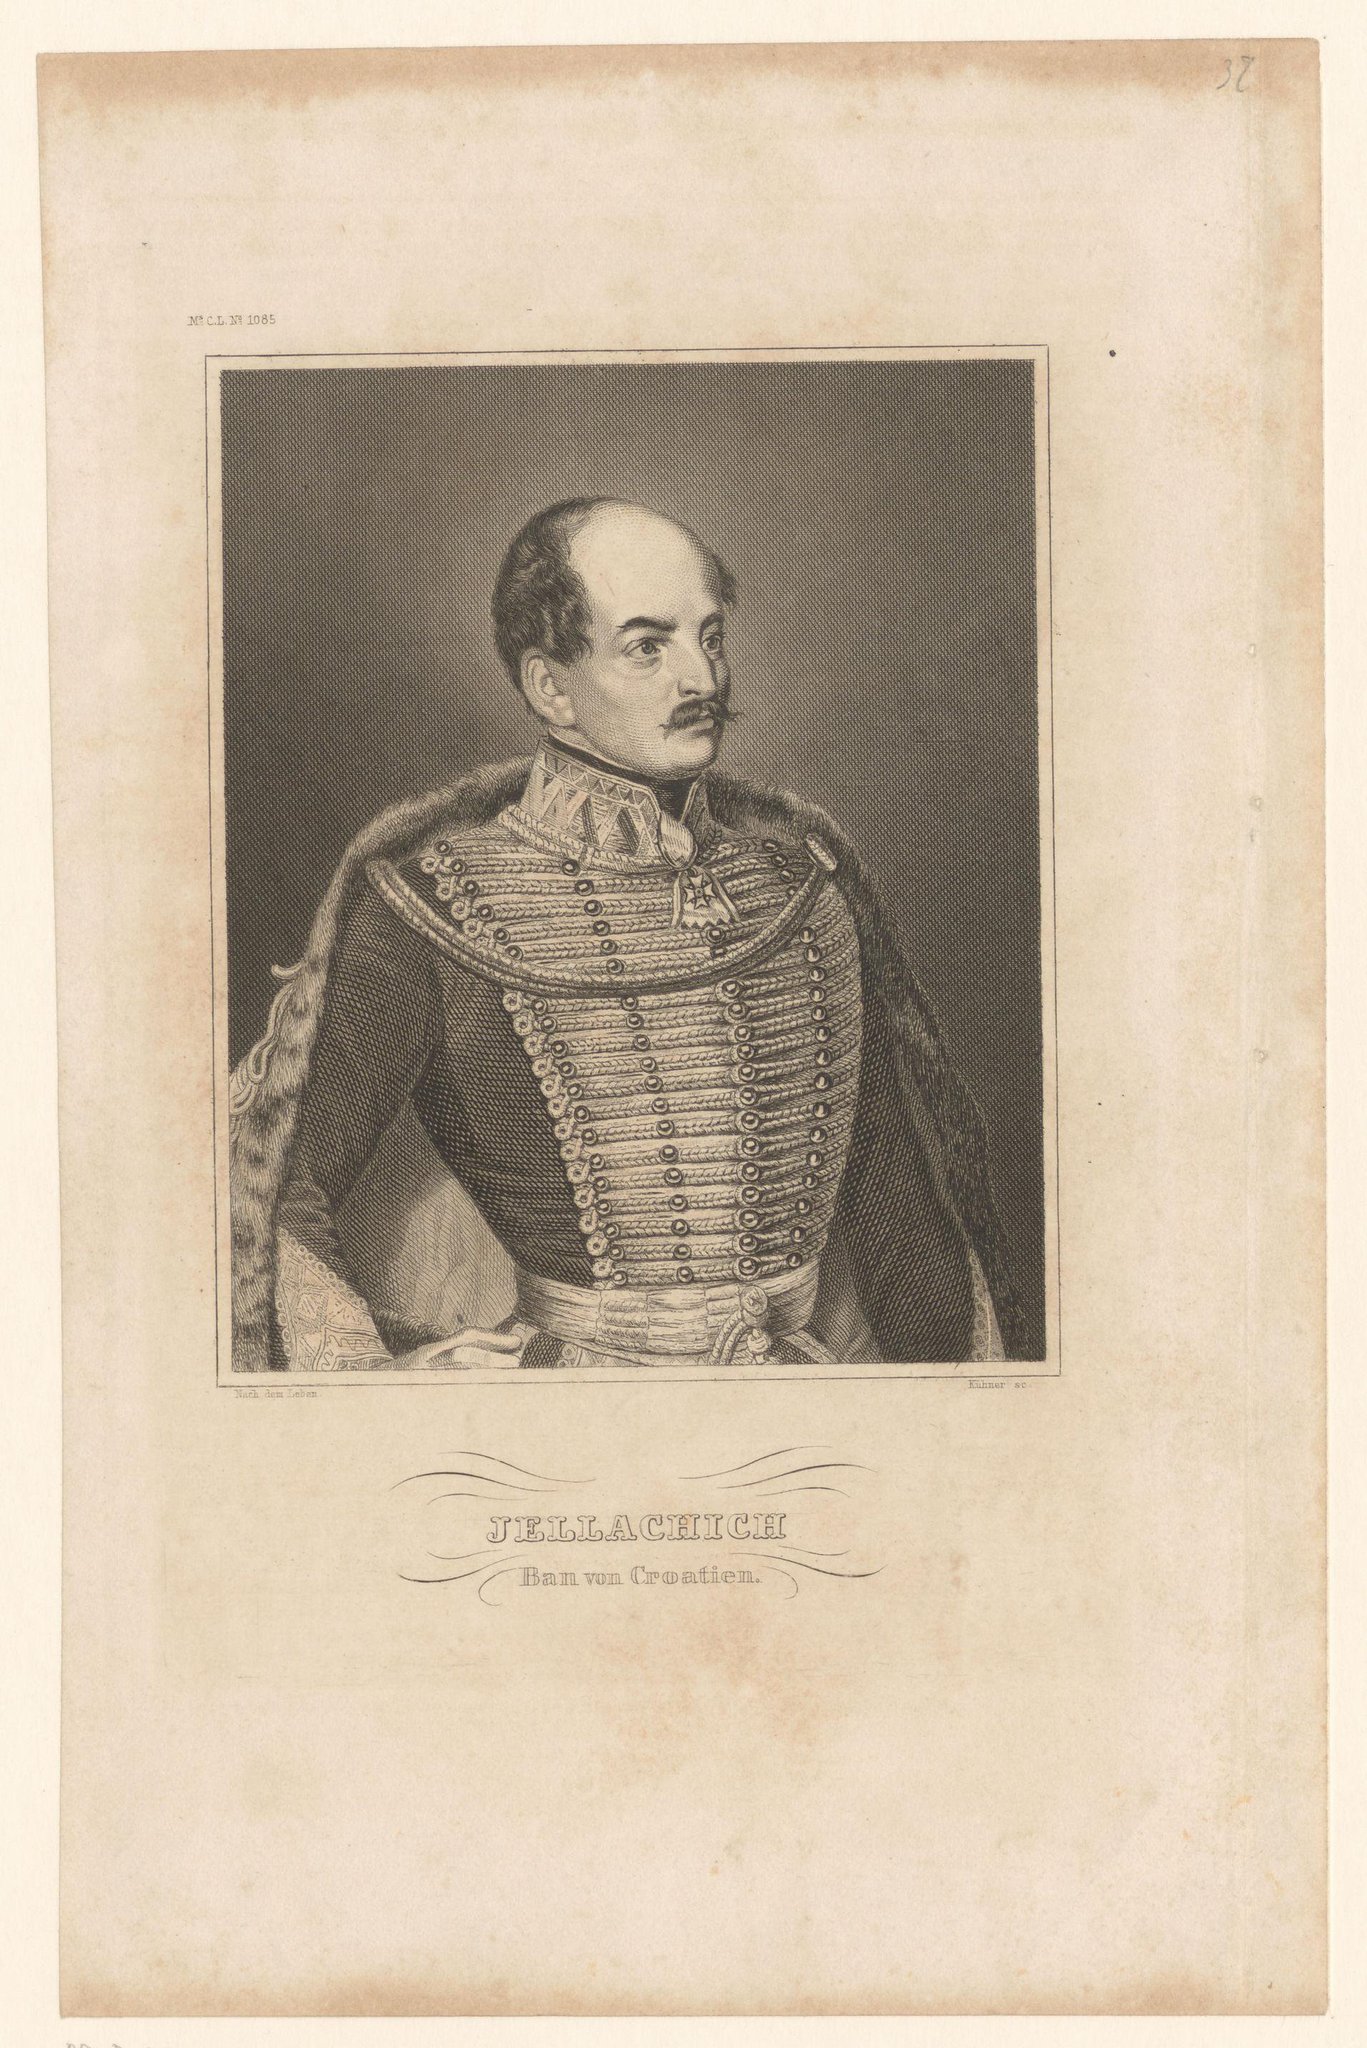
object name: book illustration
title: Portret van Josef Jellacic de Buzim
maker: johann christian friedrich kühner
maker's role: artist, painter, print maker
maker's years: 1774-1852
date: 1840-1855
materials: paper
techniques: engraving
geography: hildburghausen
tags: commander-in-chief, general, marshal, historical persons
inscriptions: collector's mark: Lugt 2228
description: Prent uit: Meyer, Joseph. Das Grosse Conversations-Lexikon für die gebildeten Stände. Hildburghausen: Bibliographisches Institut, [1840-1855].